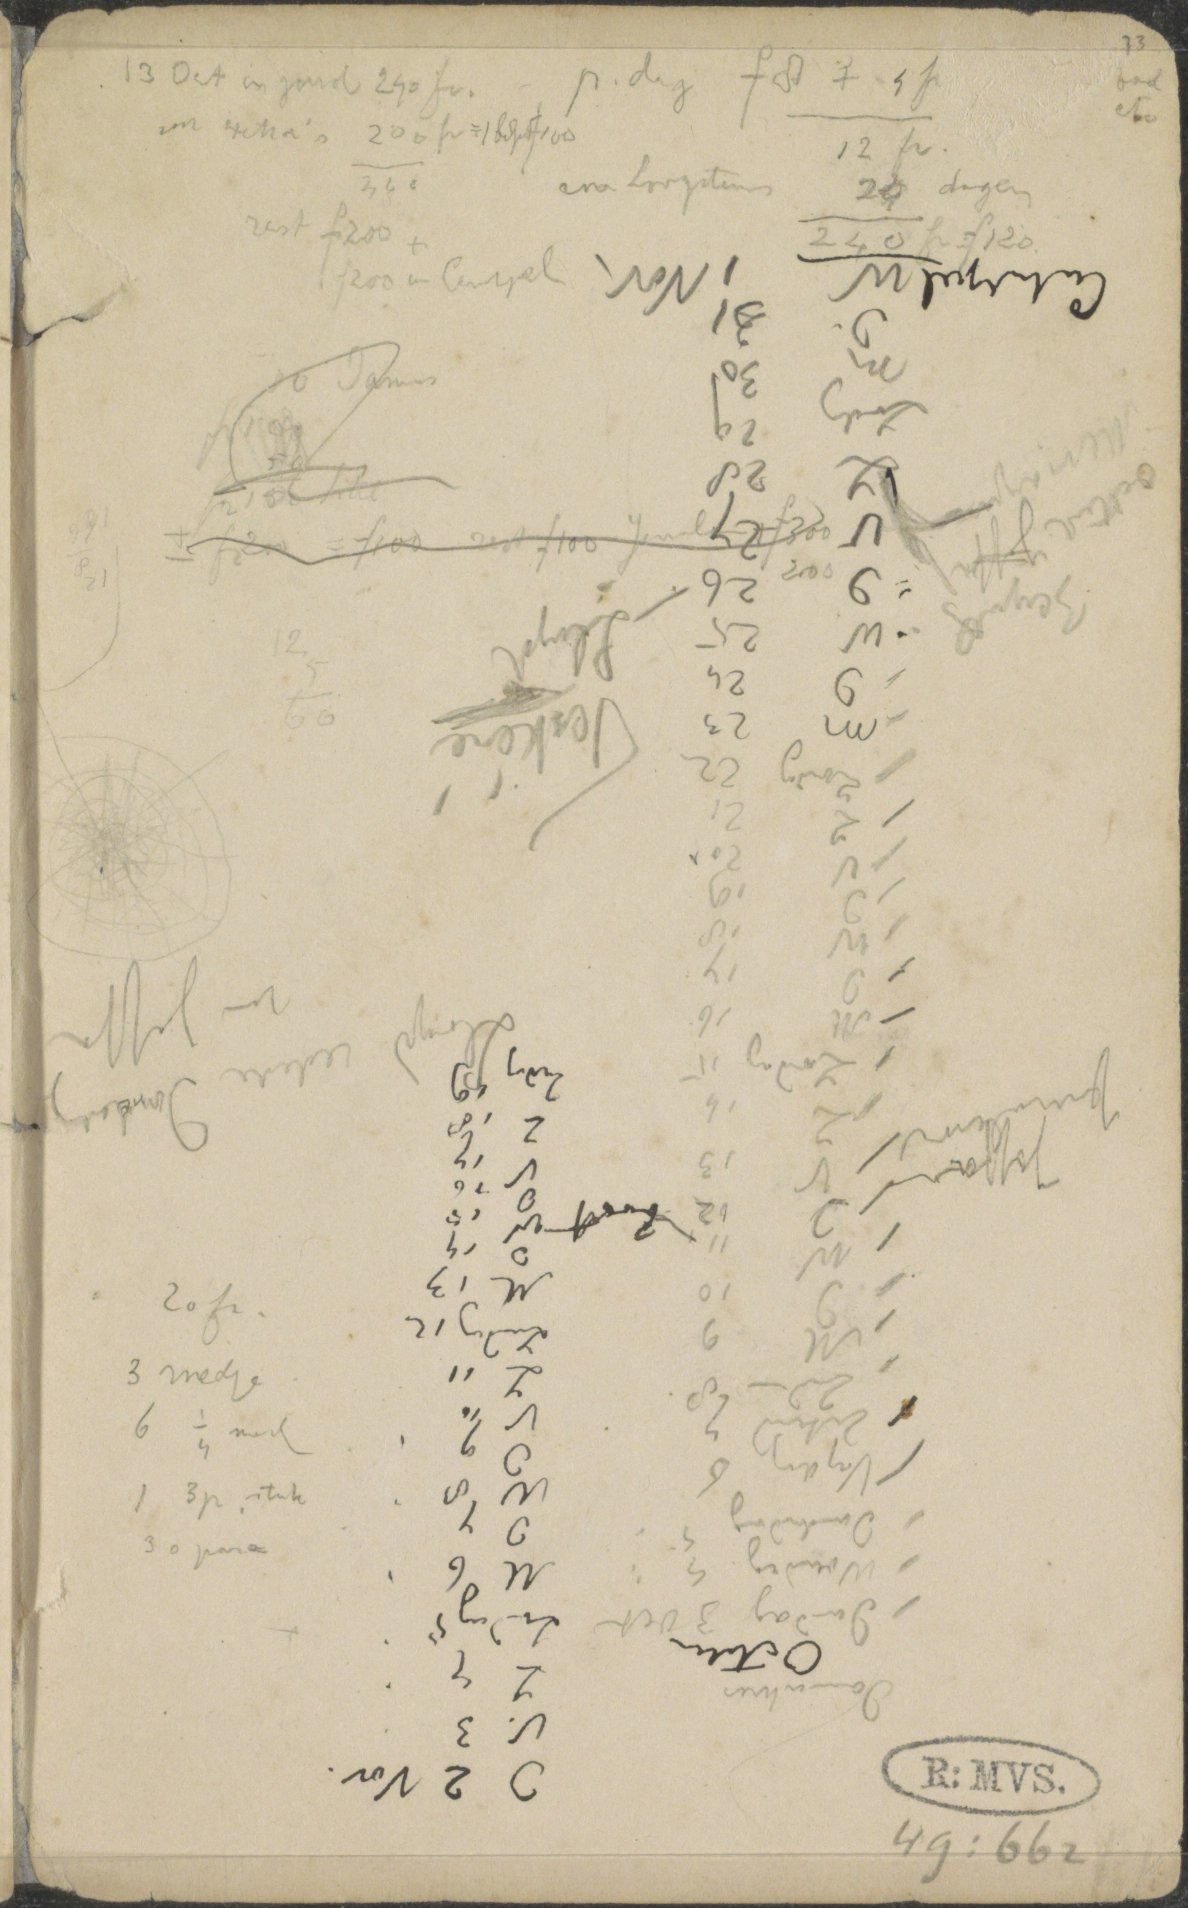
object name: sketchbook leaf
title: Reisschema en berekeningen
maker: marius bauer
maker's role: draughtsman, print maker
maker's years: 1867-1932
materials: paper, pencil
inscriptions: annotation: ‘[...]’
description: Pagina 73, achterste schutblad, uit een schetsboek met 36 bladen.